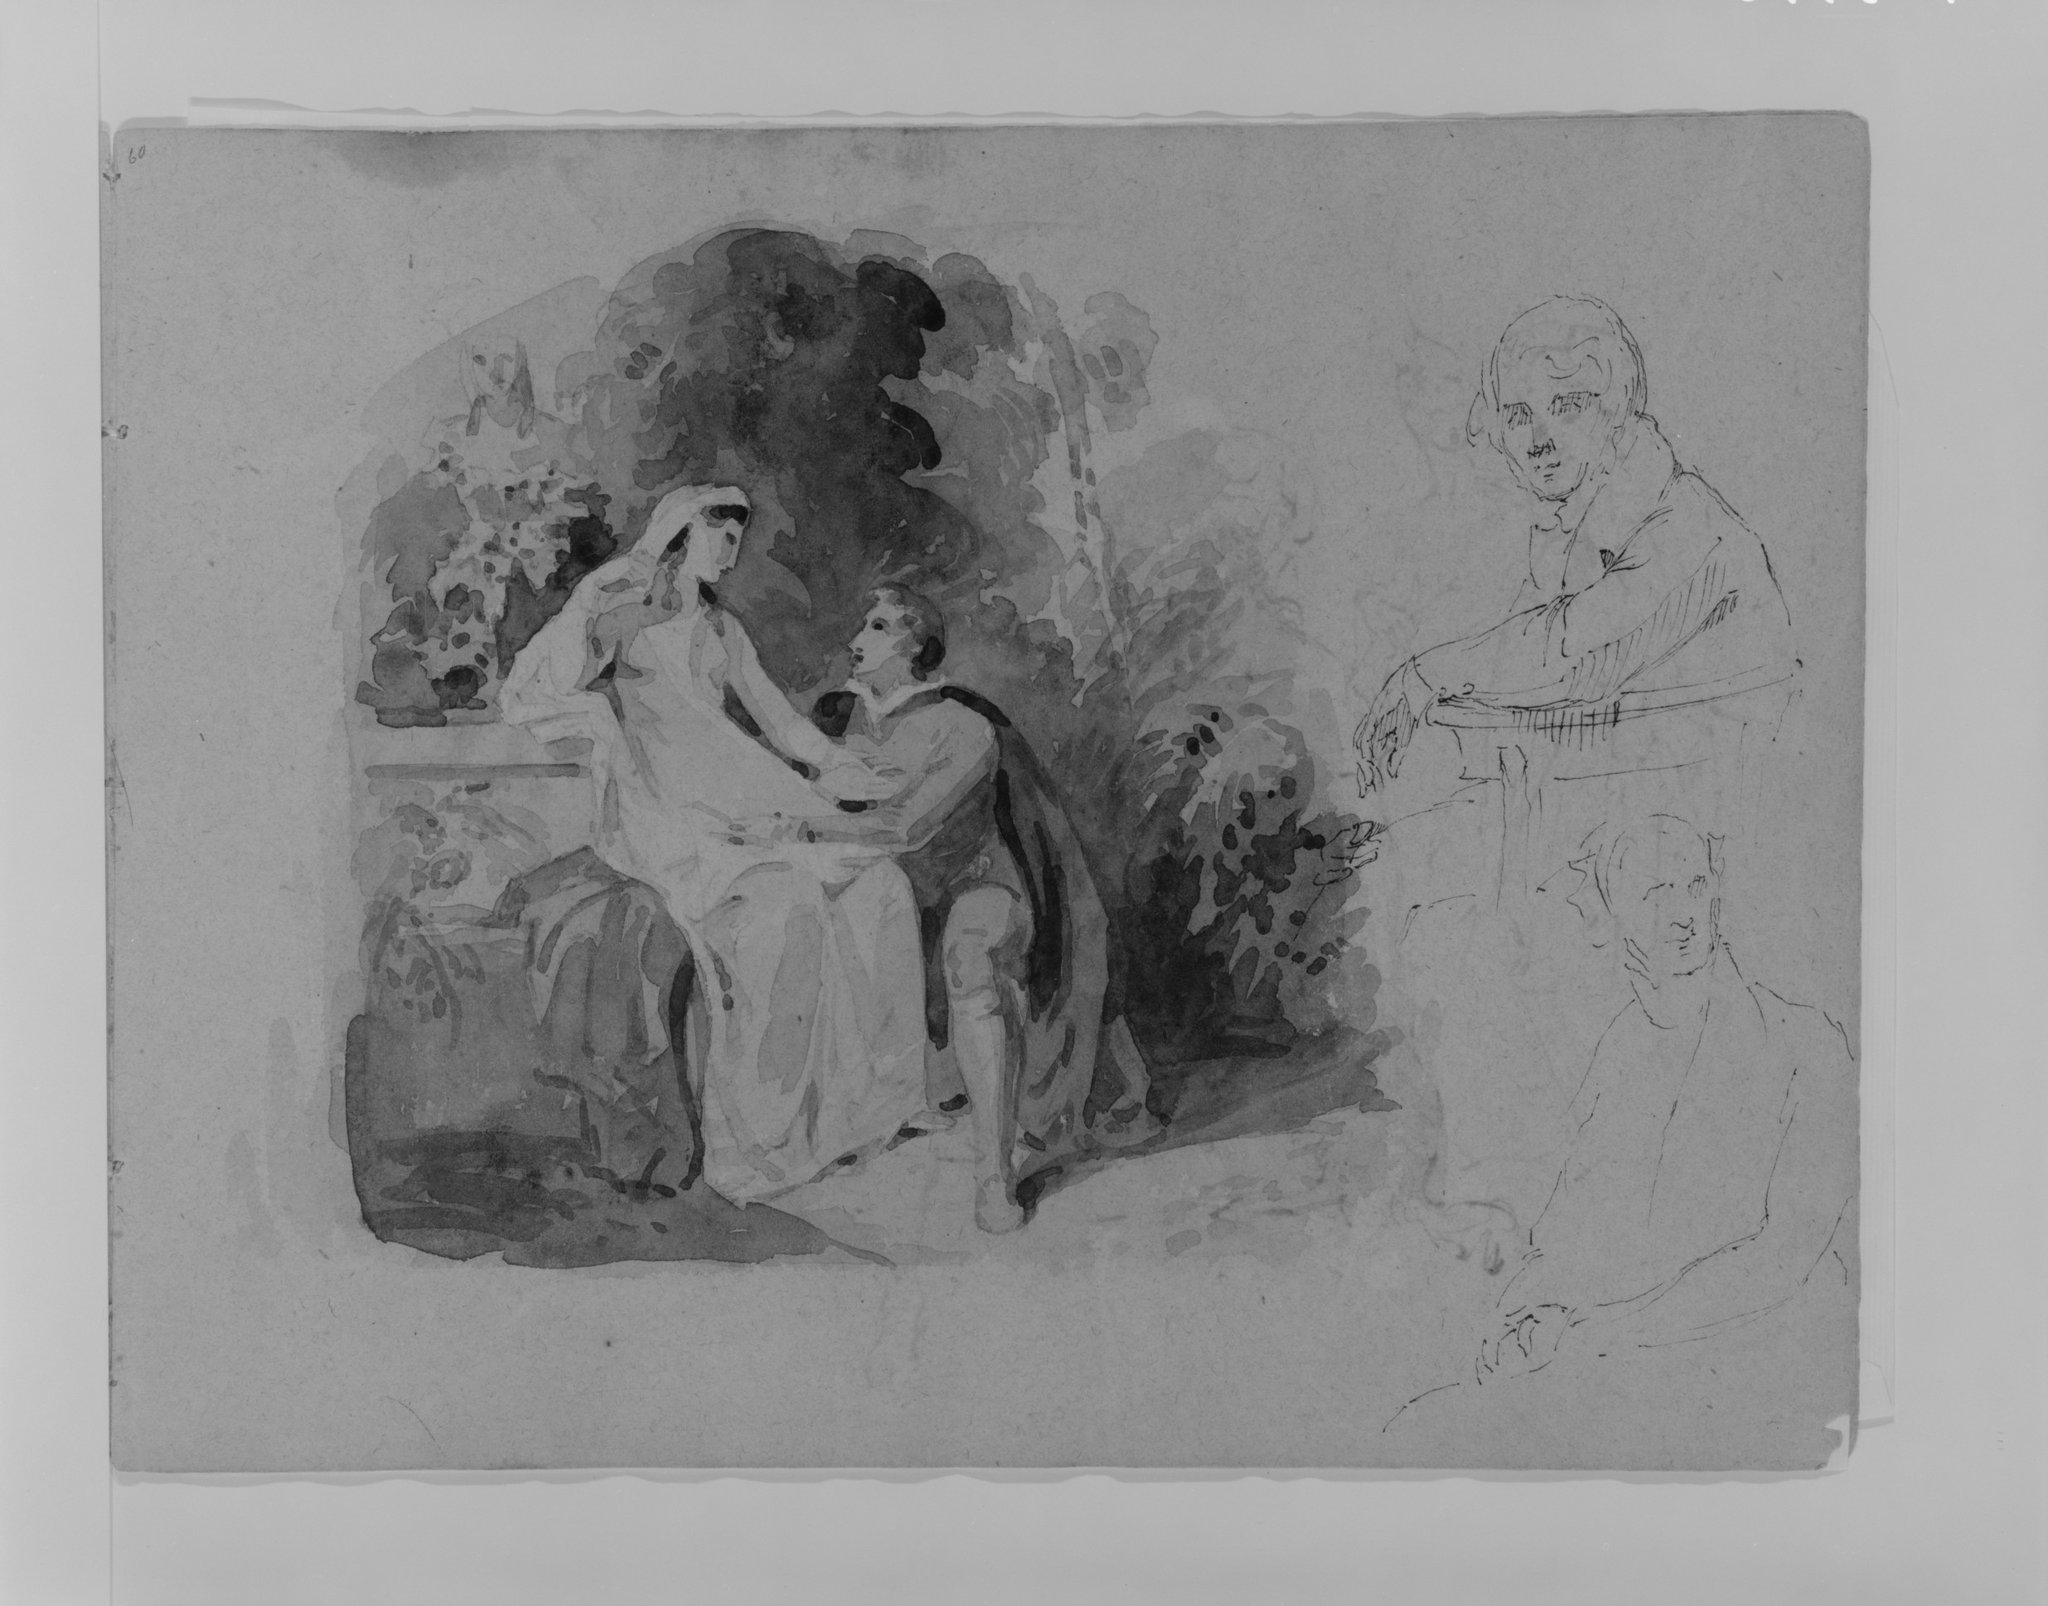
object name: drawing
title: (From Sketchbook)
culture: american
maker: thomas sully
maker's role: artist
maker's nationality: american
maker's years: 1783-1872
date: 1810-1820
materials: ink, paper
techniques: wash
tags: men,women